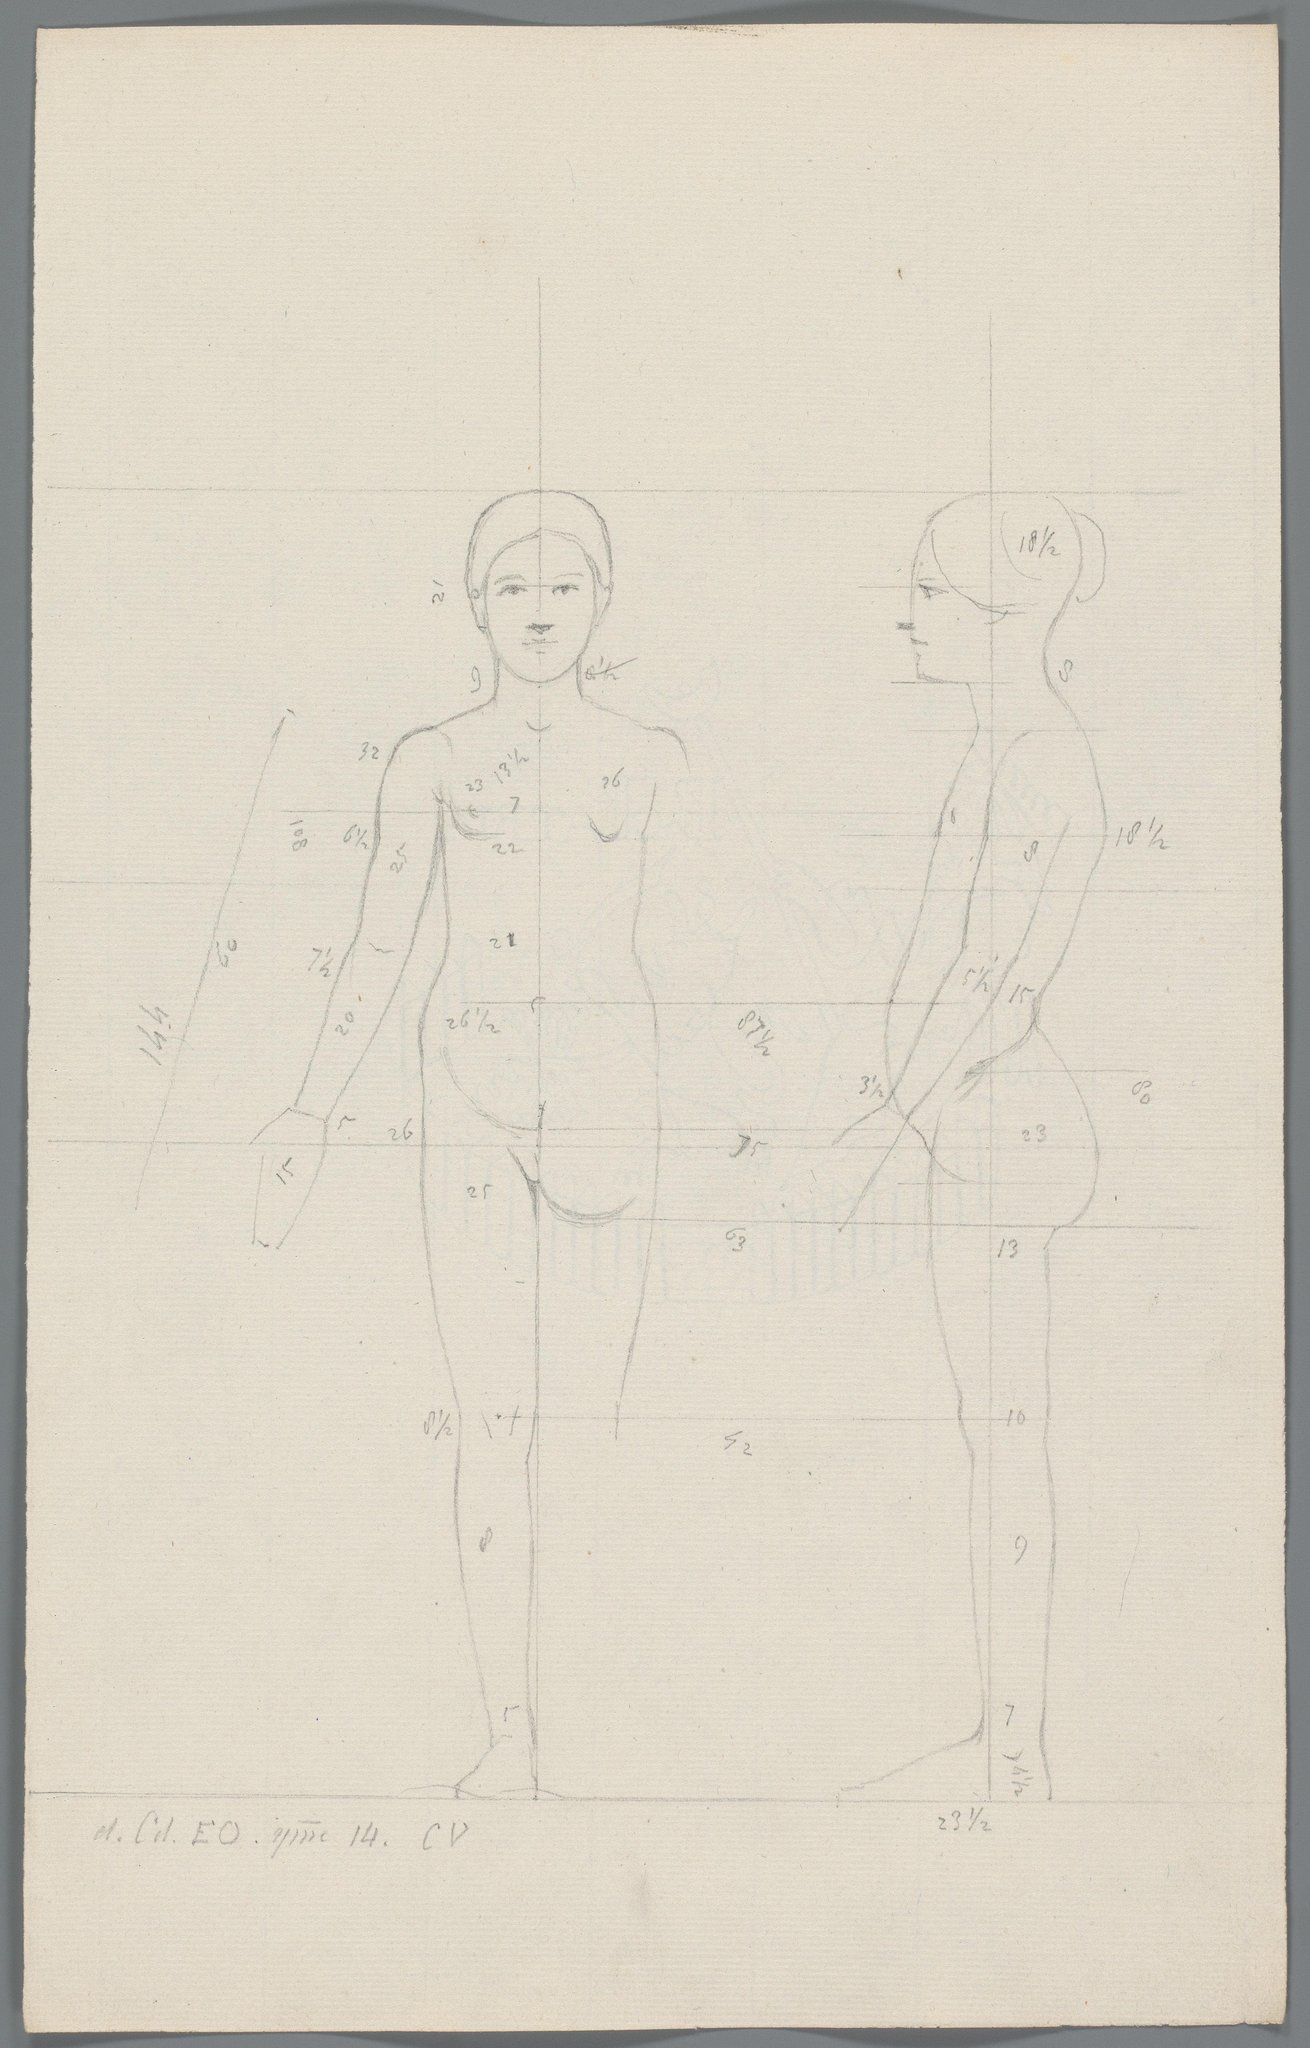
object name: drawing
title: Proportiestudie van een meisje of jonge vrouw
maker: jacobus everhardus josephus van den berg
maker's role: draughtsman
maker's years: 1802-1861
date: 1850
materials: paper, pencil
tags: adolescent, young woman, maiden, standing figure (canon, proportions) - aa - female human figure, anatomy (non-medical) - aa - female human figure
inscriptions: inscription: ‘d. Cd EO yme 14 CV’